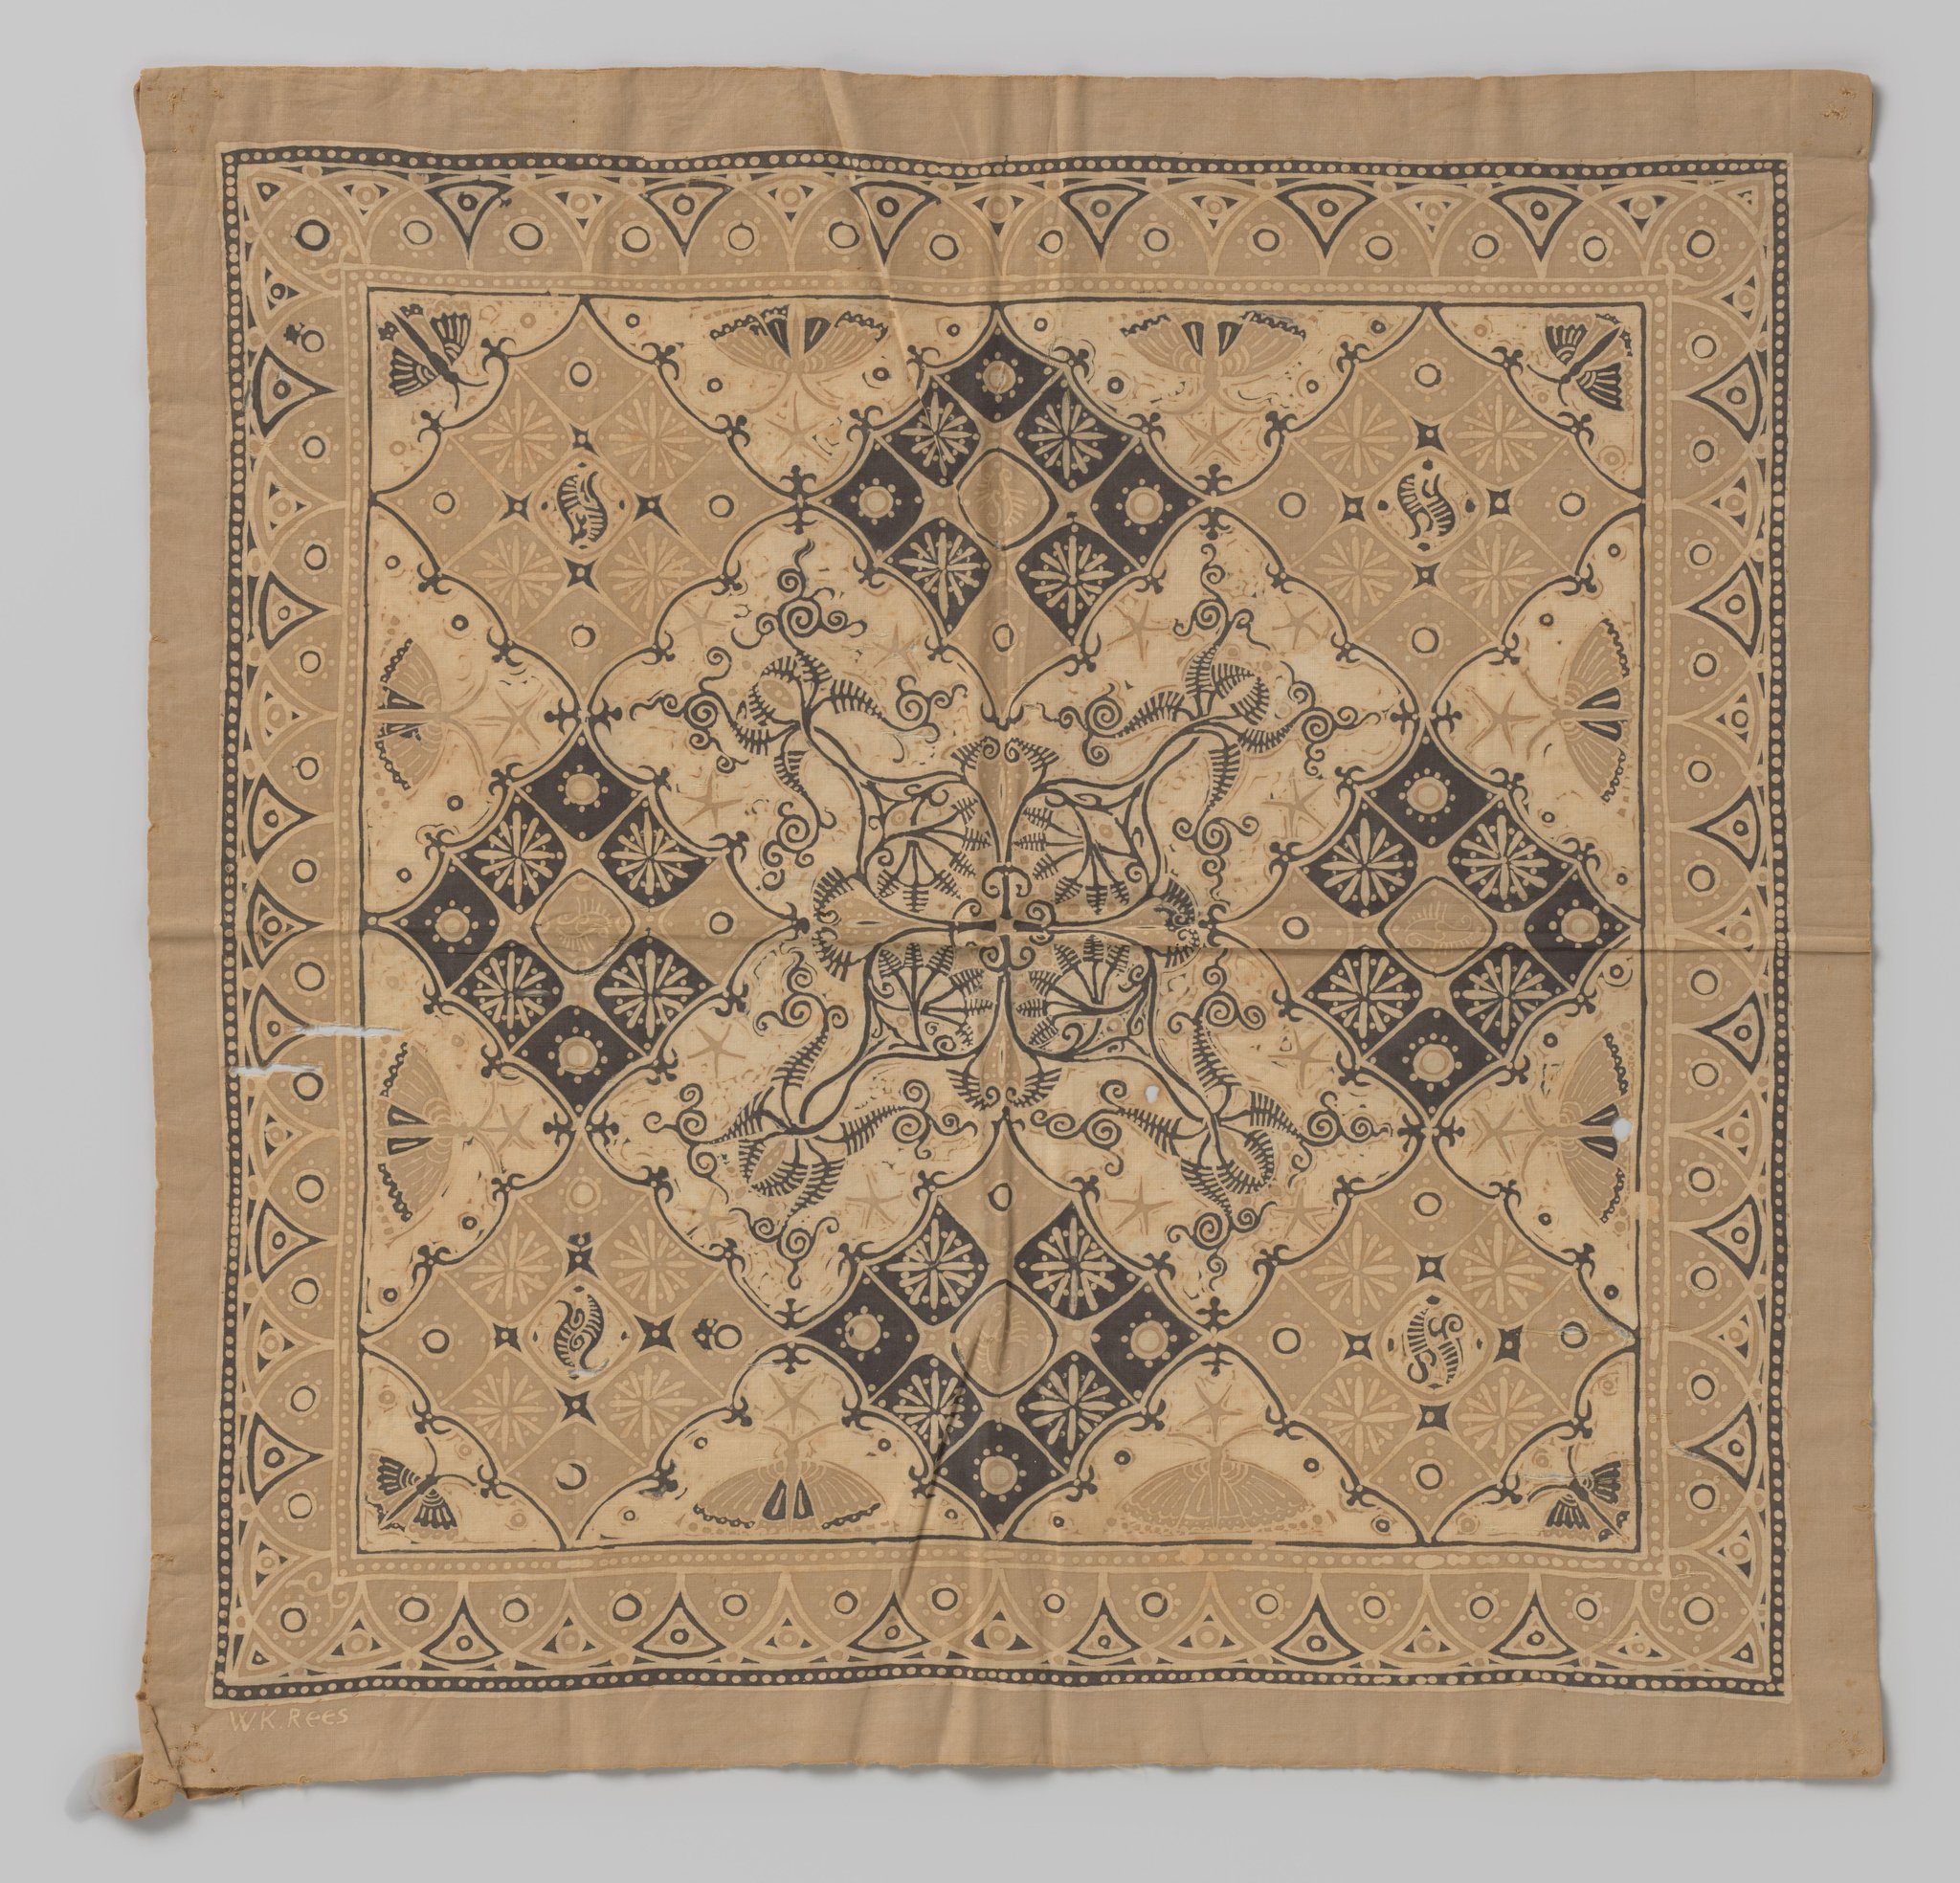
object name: sierdoek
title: Gebatikte sierdoek met gestileerde vlinders en sterren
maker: willem karel rees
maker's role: designer, painter, print maker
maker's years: 1880-1962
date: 1910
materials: linen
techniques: batik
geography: haarlem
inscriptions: signature: ‘W K. Rees’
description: Gebatikte sierdoek van linnen met een dessin van gestileerde motieven (onder andere vlinders en sterren) in een ruitvorm, in zwart/bruin en beige op een écru fond.